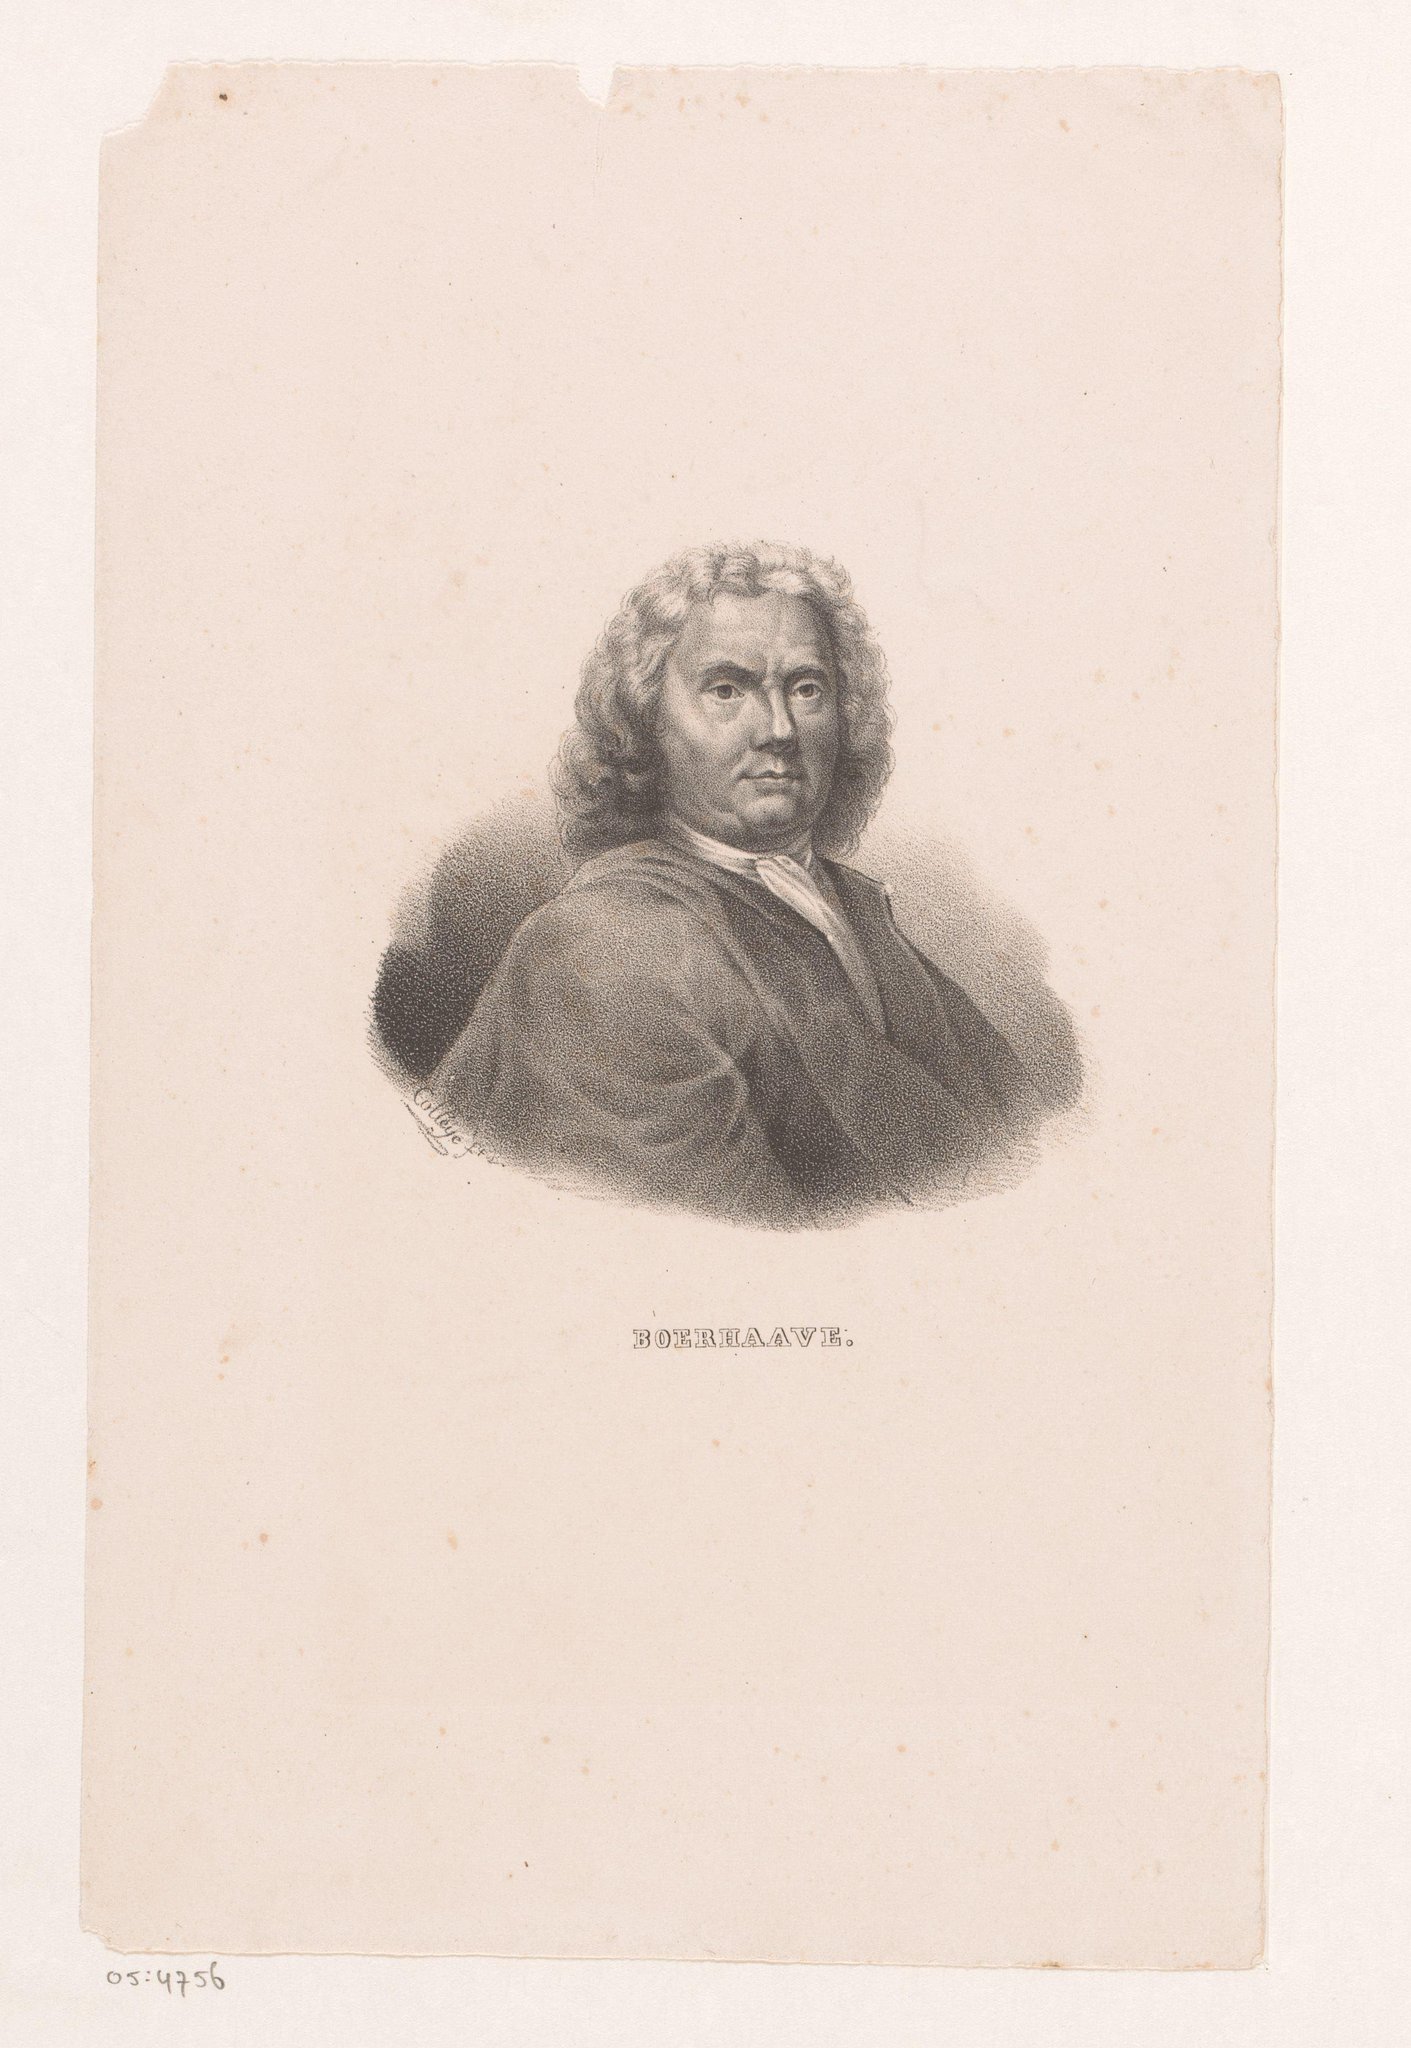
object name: print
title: Portret van Hermanus Boerhaave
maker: h.i. colleye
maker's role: print maker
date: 1800-1849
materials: paper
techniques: lithograph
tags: hermanus boerhaave, adult man, historical persons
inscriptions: collector's mark: Lugt 2228